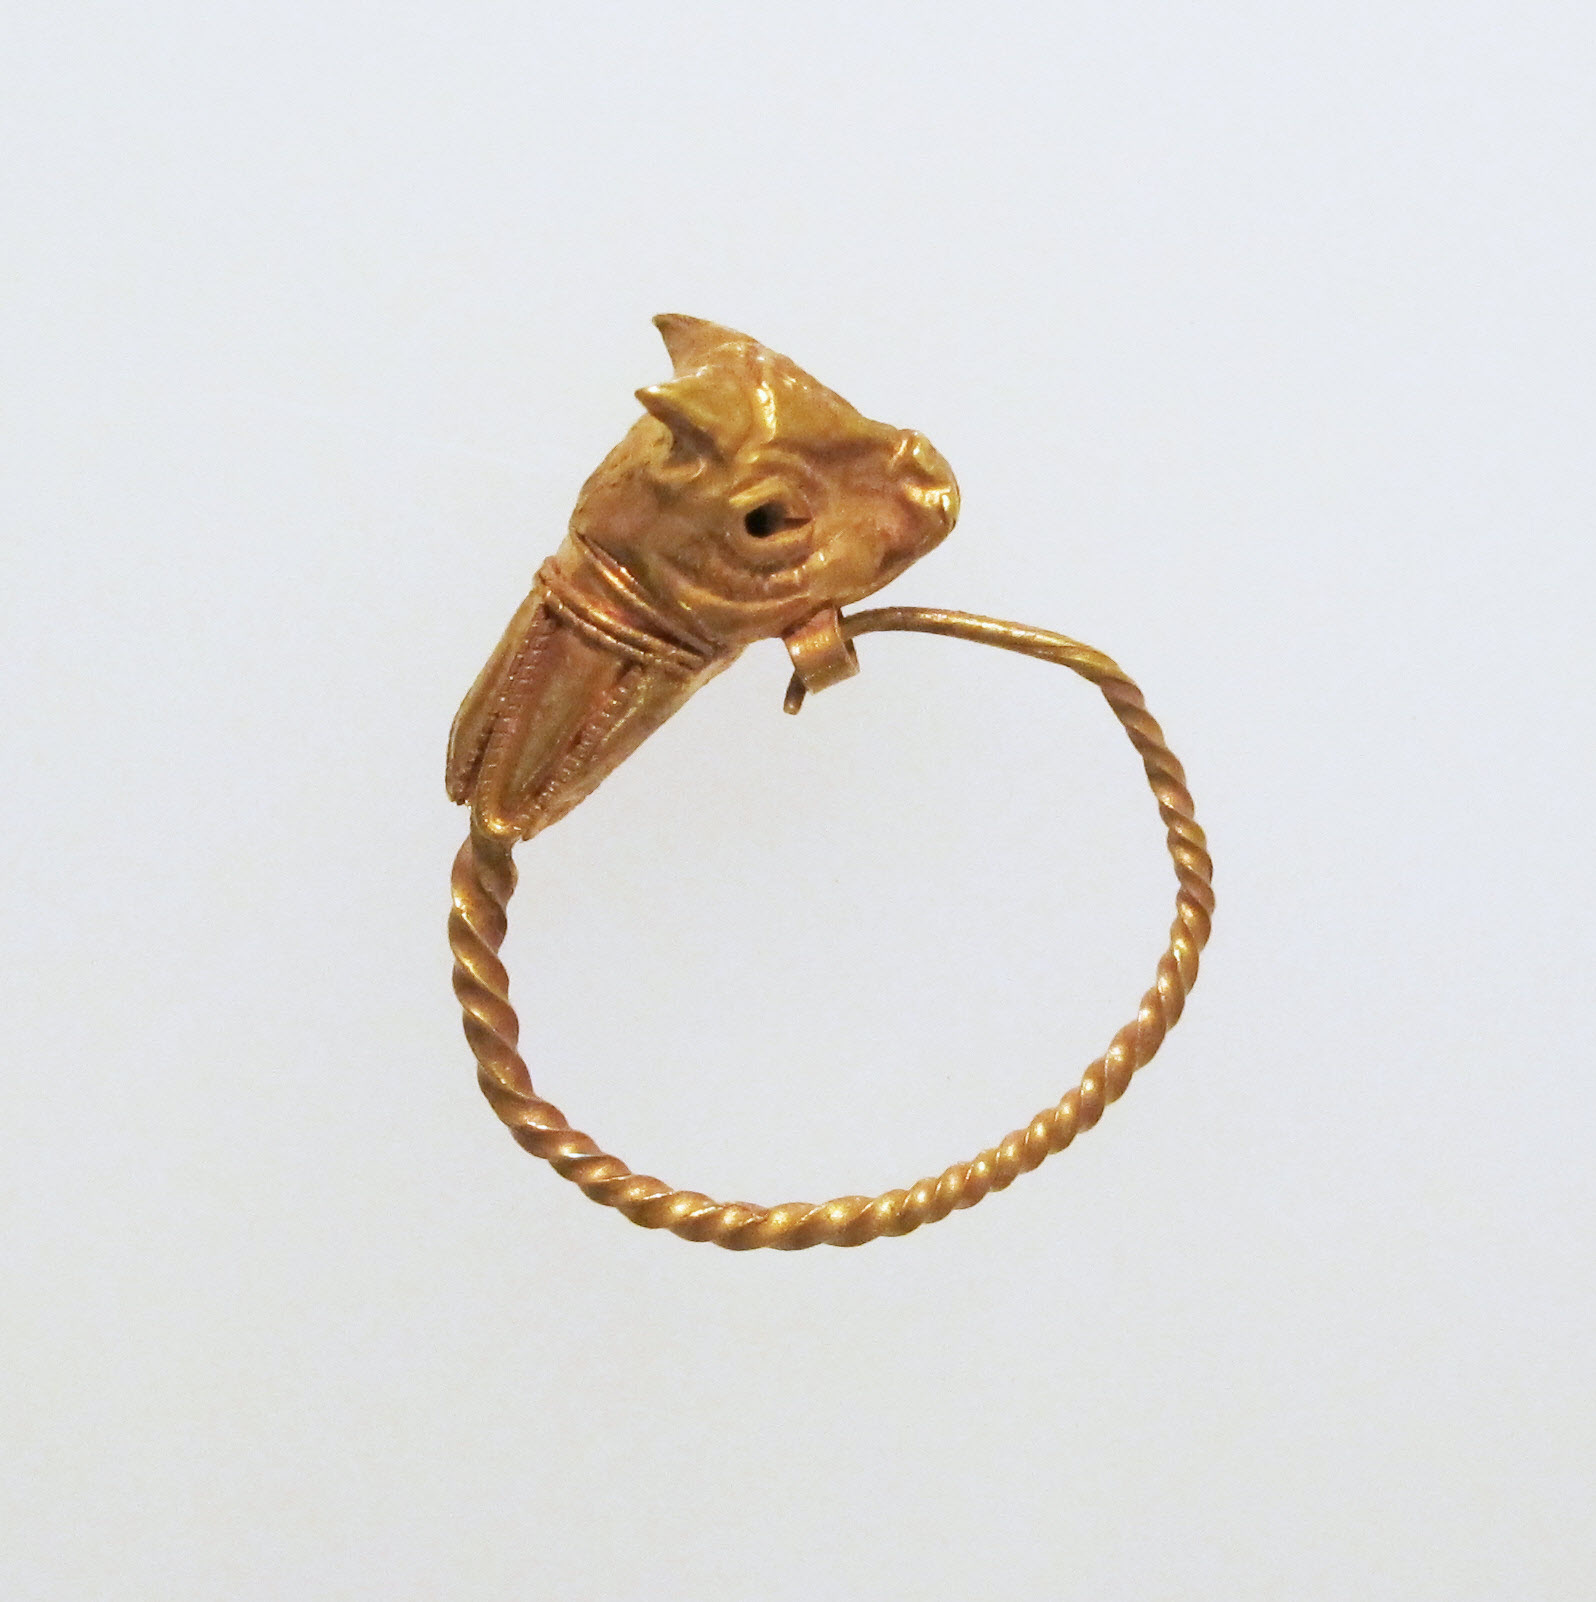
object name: earring with head of bull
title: Gold earring with head of a bull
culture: greek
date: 400-201 BCE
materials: gold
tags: bulls